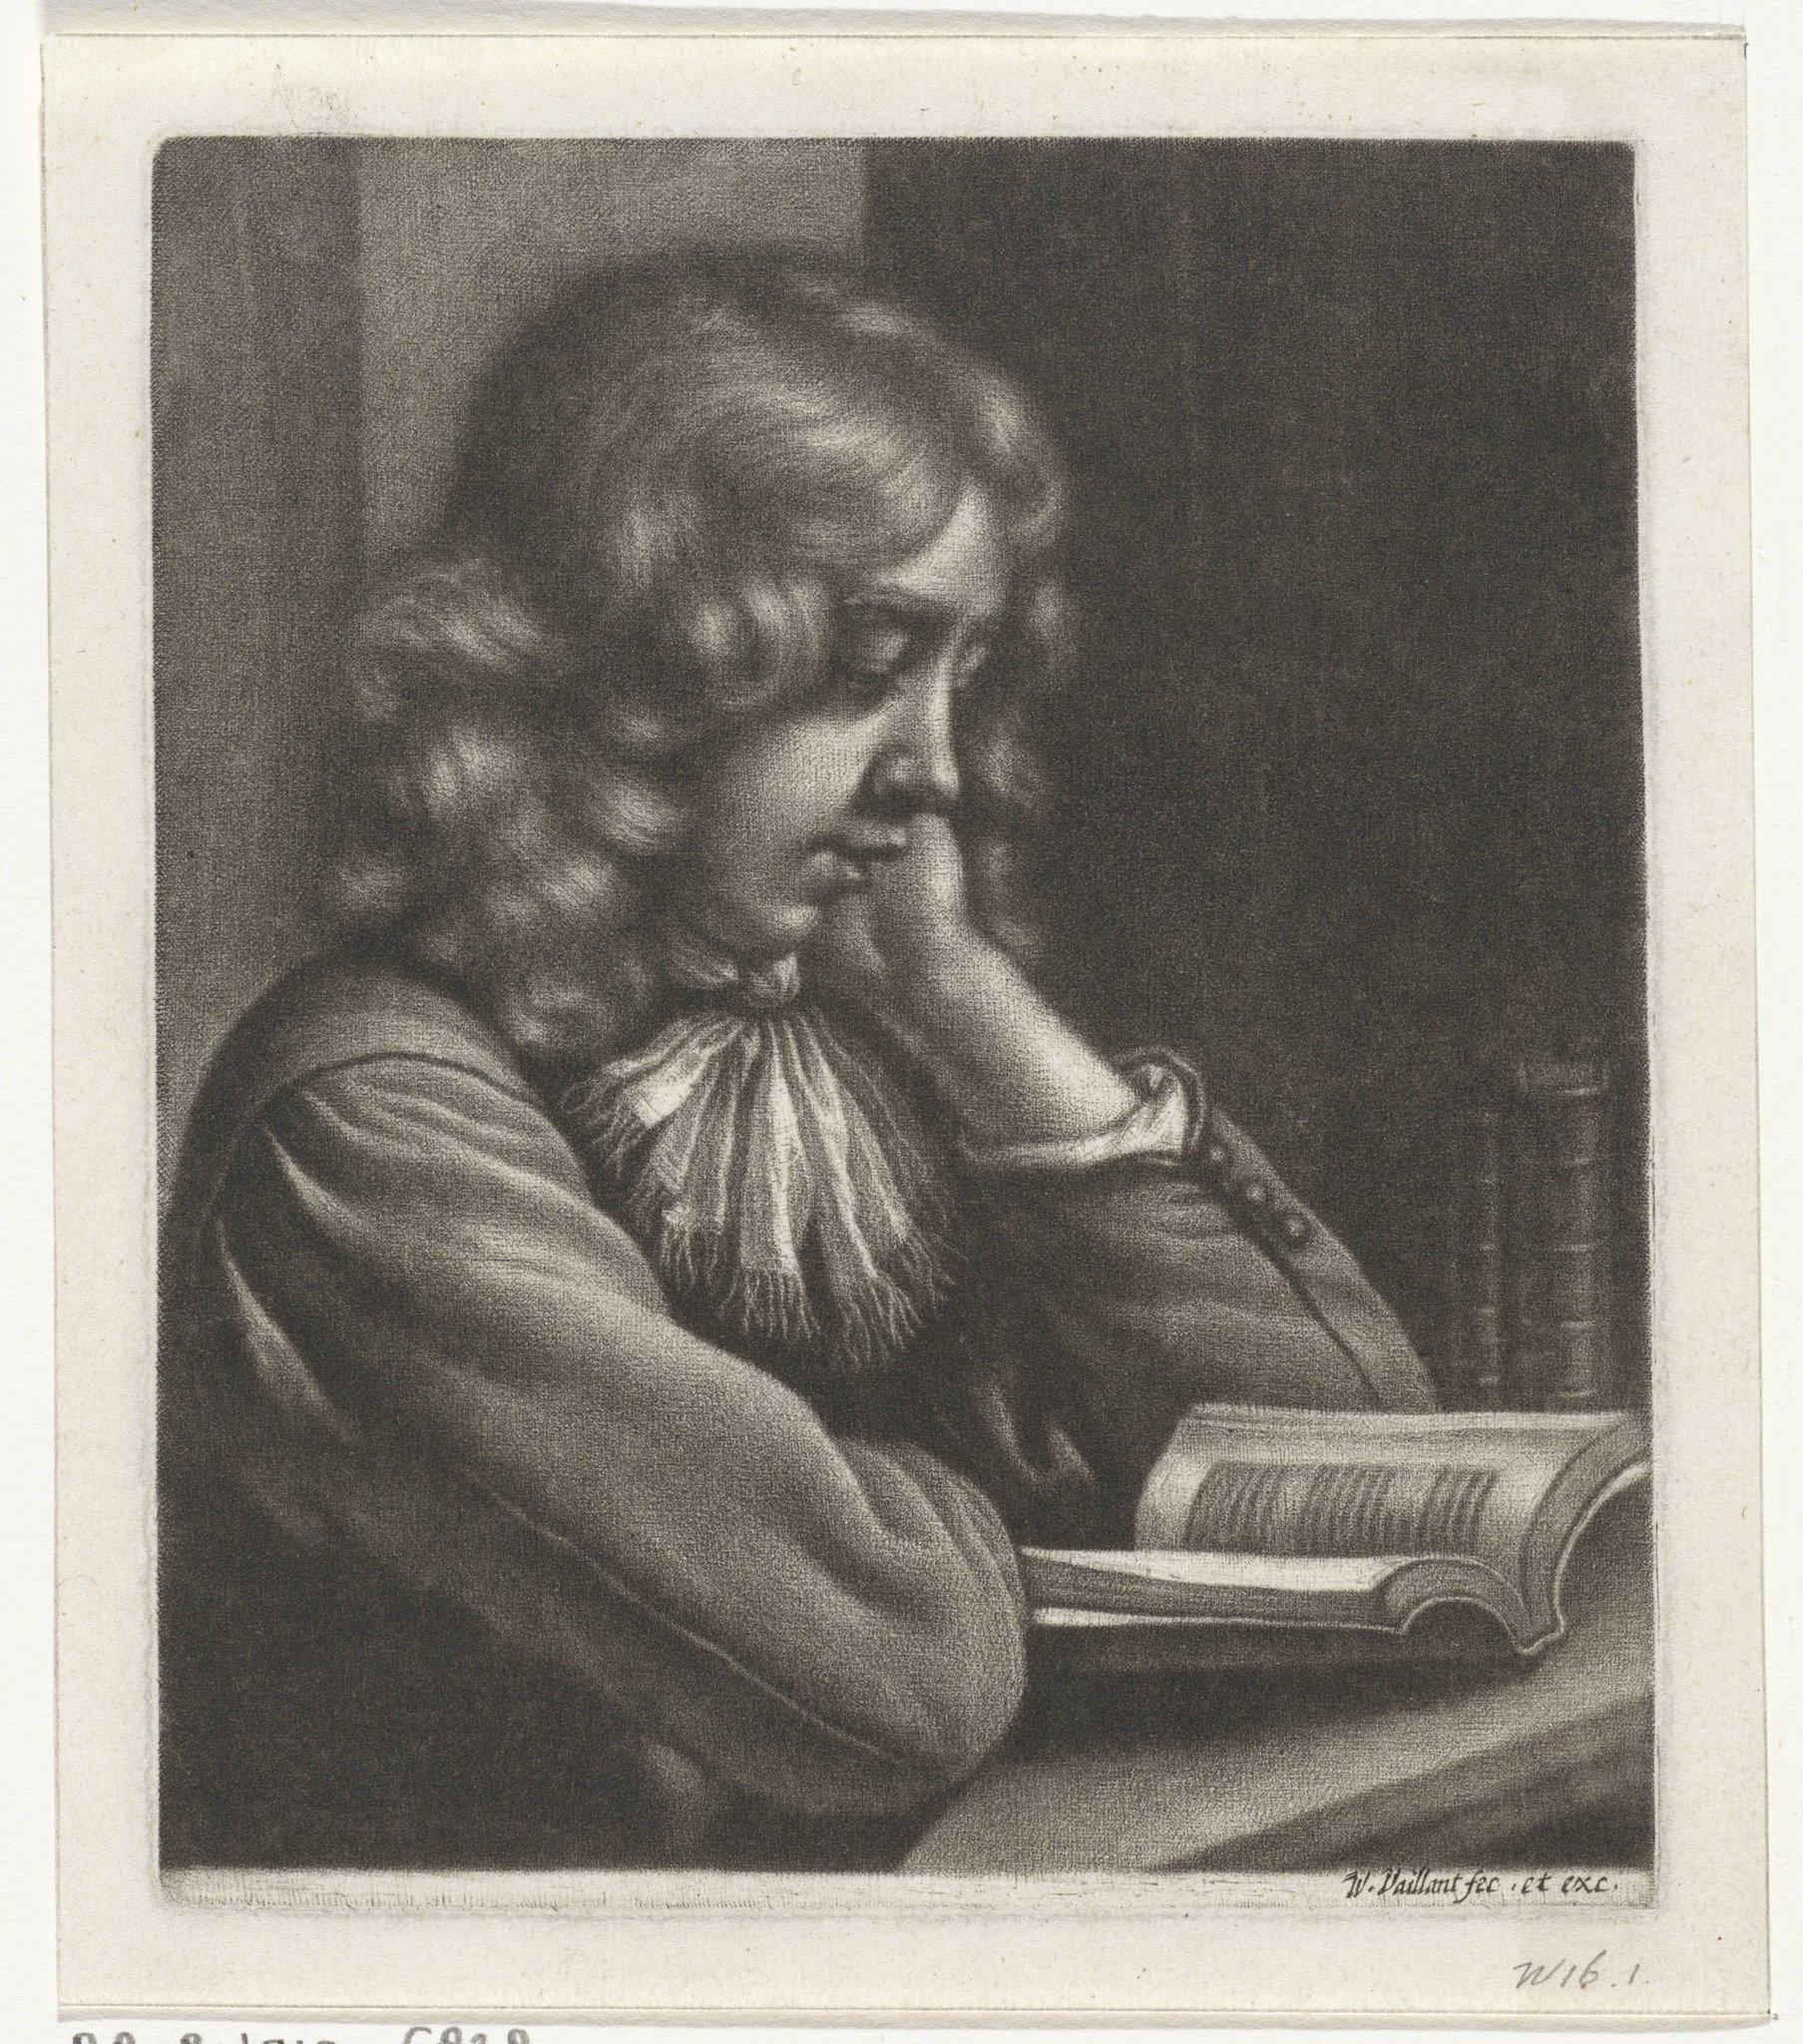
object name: print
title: Lezende jongen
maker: wallerant vaillant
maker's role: draughtsman, painter, print maker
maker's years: 1623-1677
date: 1658-1677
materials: paper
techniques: mezzotint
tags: reading, book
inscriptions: collector's mark: Lugt 2228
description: Een jongen zit aan een bureau een boek te lezen.